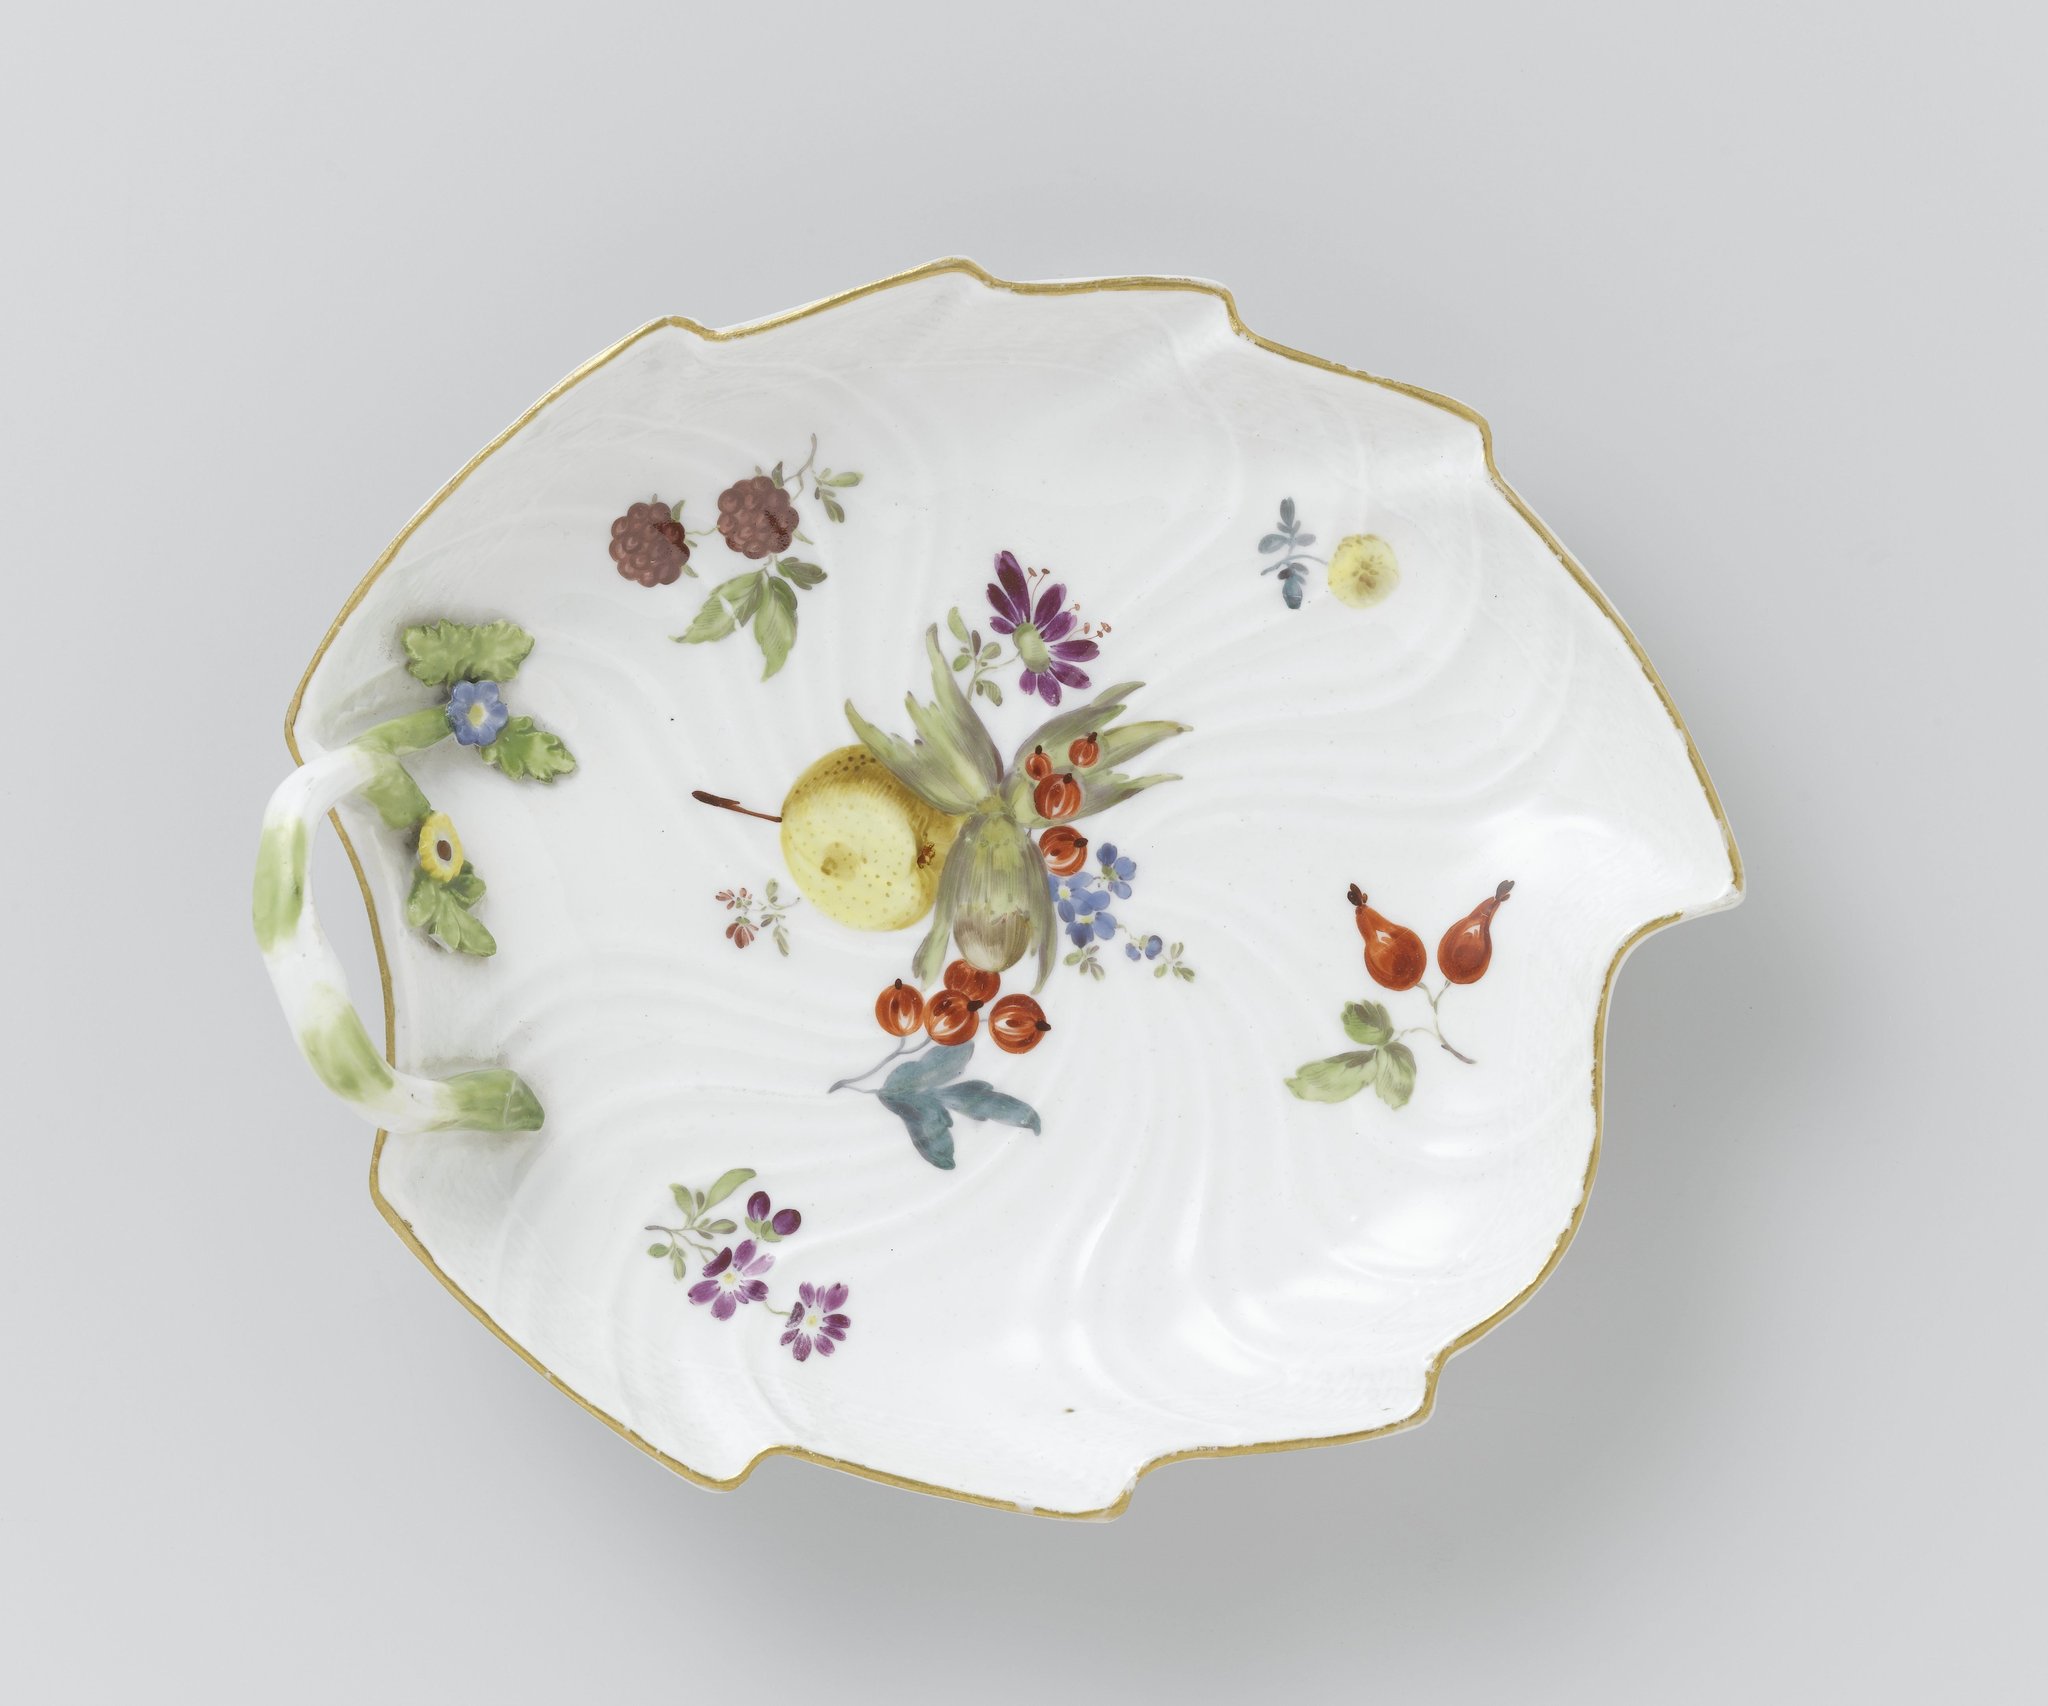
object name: eating drinking utensil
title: Schotel, veelkleurig beschilderd met Deutsche Blumen, insekten en vruchten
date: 1750-1760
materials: porcelain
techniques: painted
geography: meissen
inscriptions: factory mark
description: Schotel in de vorm van een getand blad met een oor in de vorm van een groene tak met plastische bloemen en bladeren. De schotel is beschilderd met Deutsche Blumen, insekten en vruchten. De schotel vormt met vier schotels een nest (BK-17474-14 t/m BK-17474-18). De schotels horen bij een servies (BK-17474-1 t/m BK-17474-253). De schotel is gemerkt.